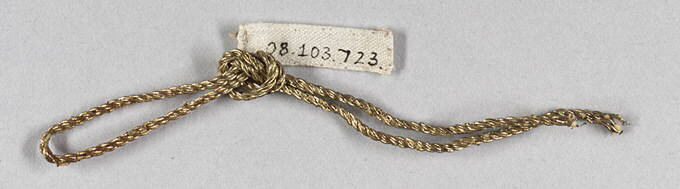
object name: thread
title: Tinsel and metal thread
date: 1601-1800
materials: metal thread